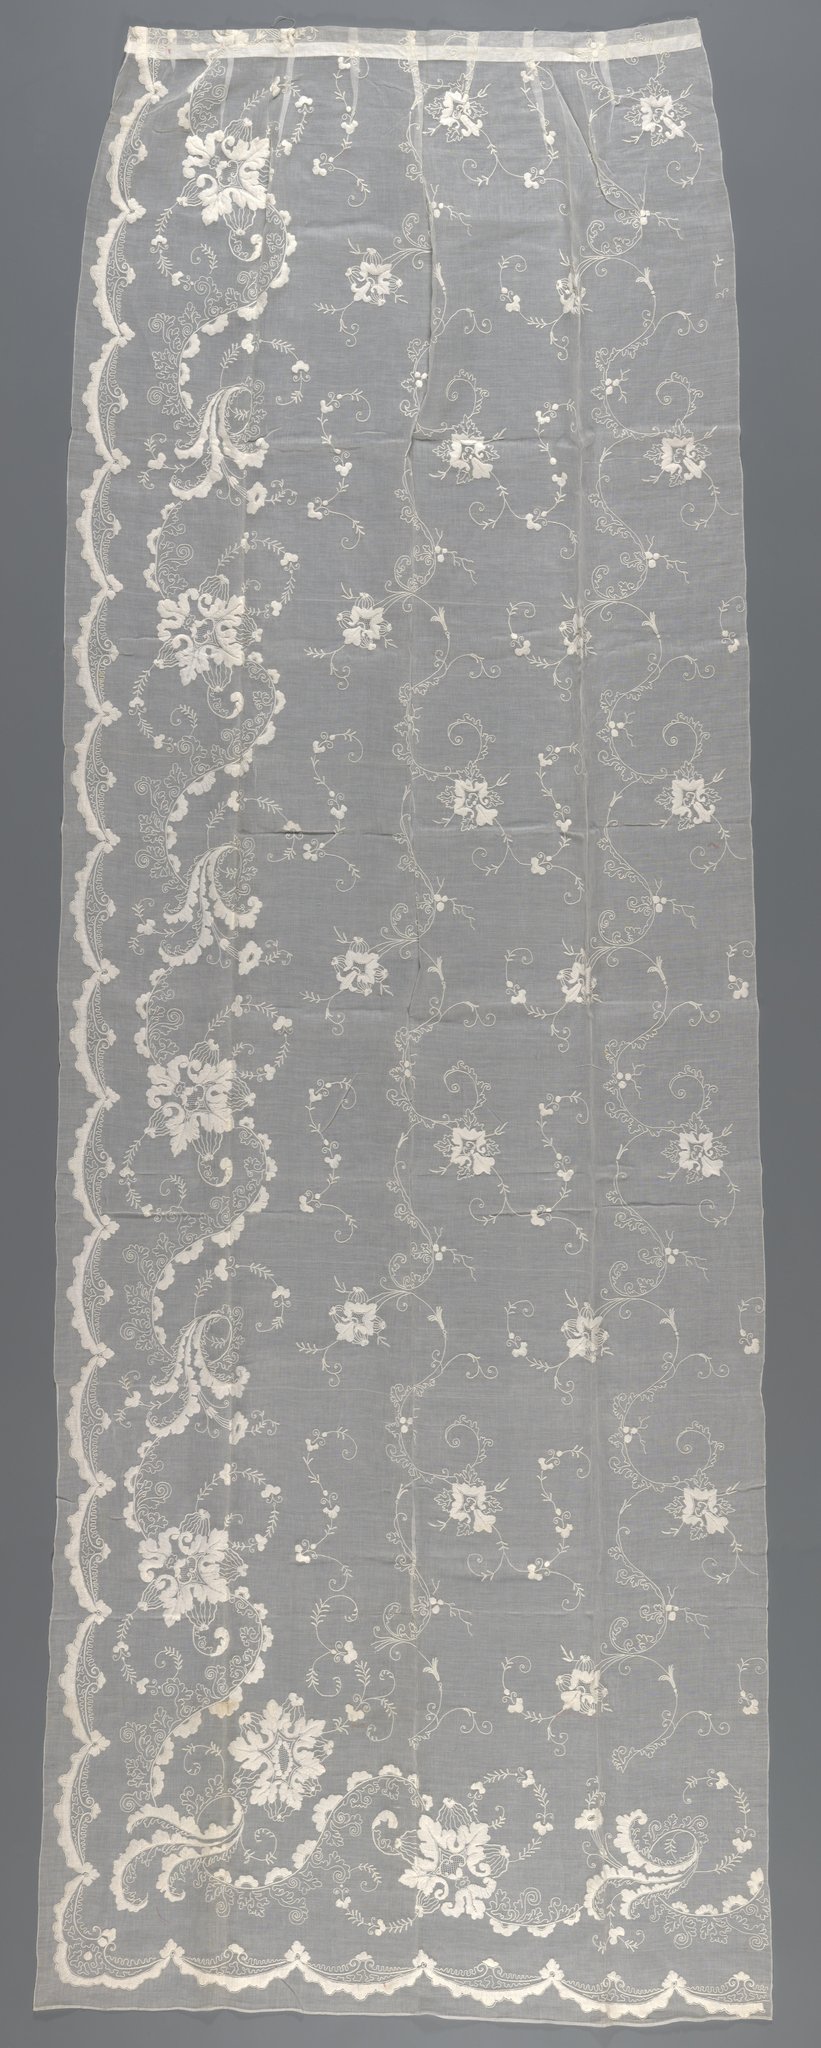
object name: bed curtain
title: Bedgordijn van glasbatist, versierd met tule doorstopborduursel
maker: Anonymous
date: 1800-1874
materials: textile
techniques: stopwork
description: Bedgordijn van glasbatist, versierd met tule doorstopborduursel (wit op wit) in de vorm van bloemornament en voluten.